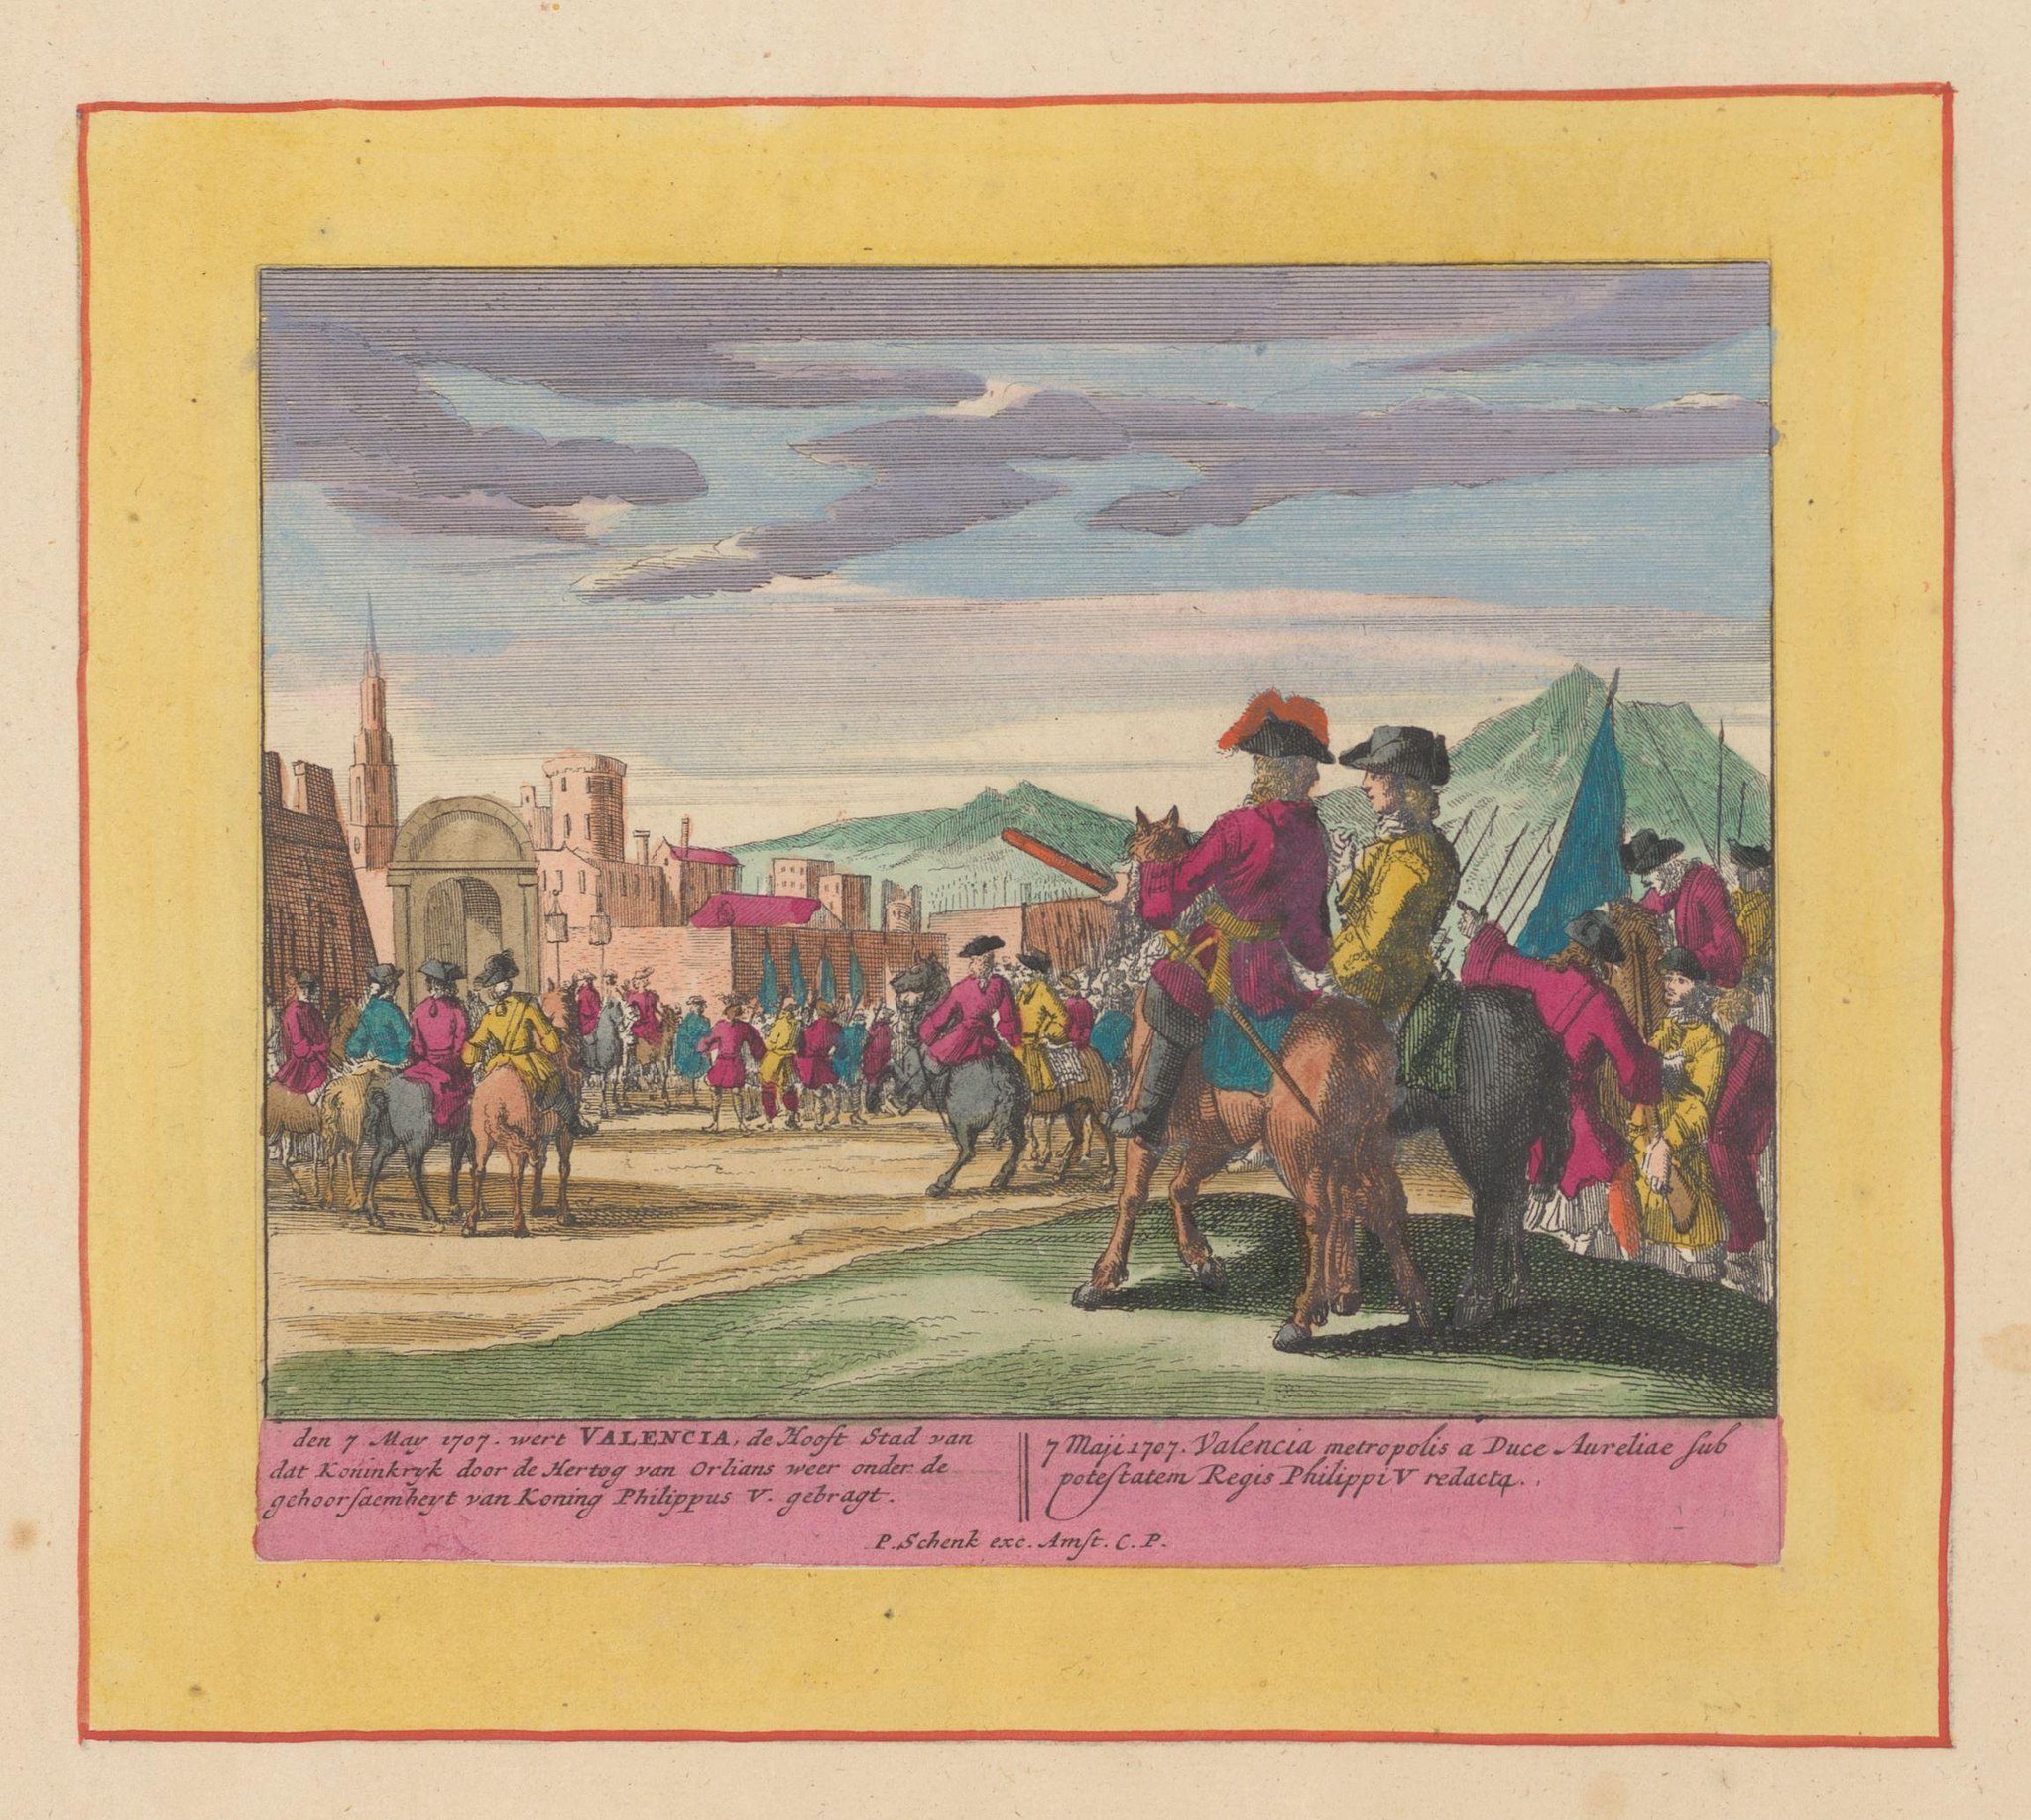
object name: album leaf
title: Inname van Valencia, 1707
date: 1707-1720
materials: paper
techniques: etching, hand coloring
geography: amsterdam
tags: war and peace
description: Prent uit: Schouwburg van den oorlog, beginnende van Karel den II. tot op koning Karel den III. : bestaande in IX historische figuren op een olifants blad, als veldslagen, belegeringen te water en te lande, met de voornaamste vestingen. Amsterdam: Pieter Schenk, 1709.